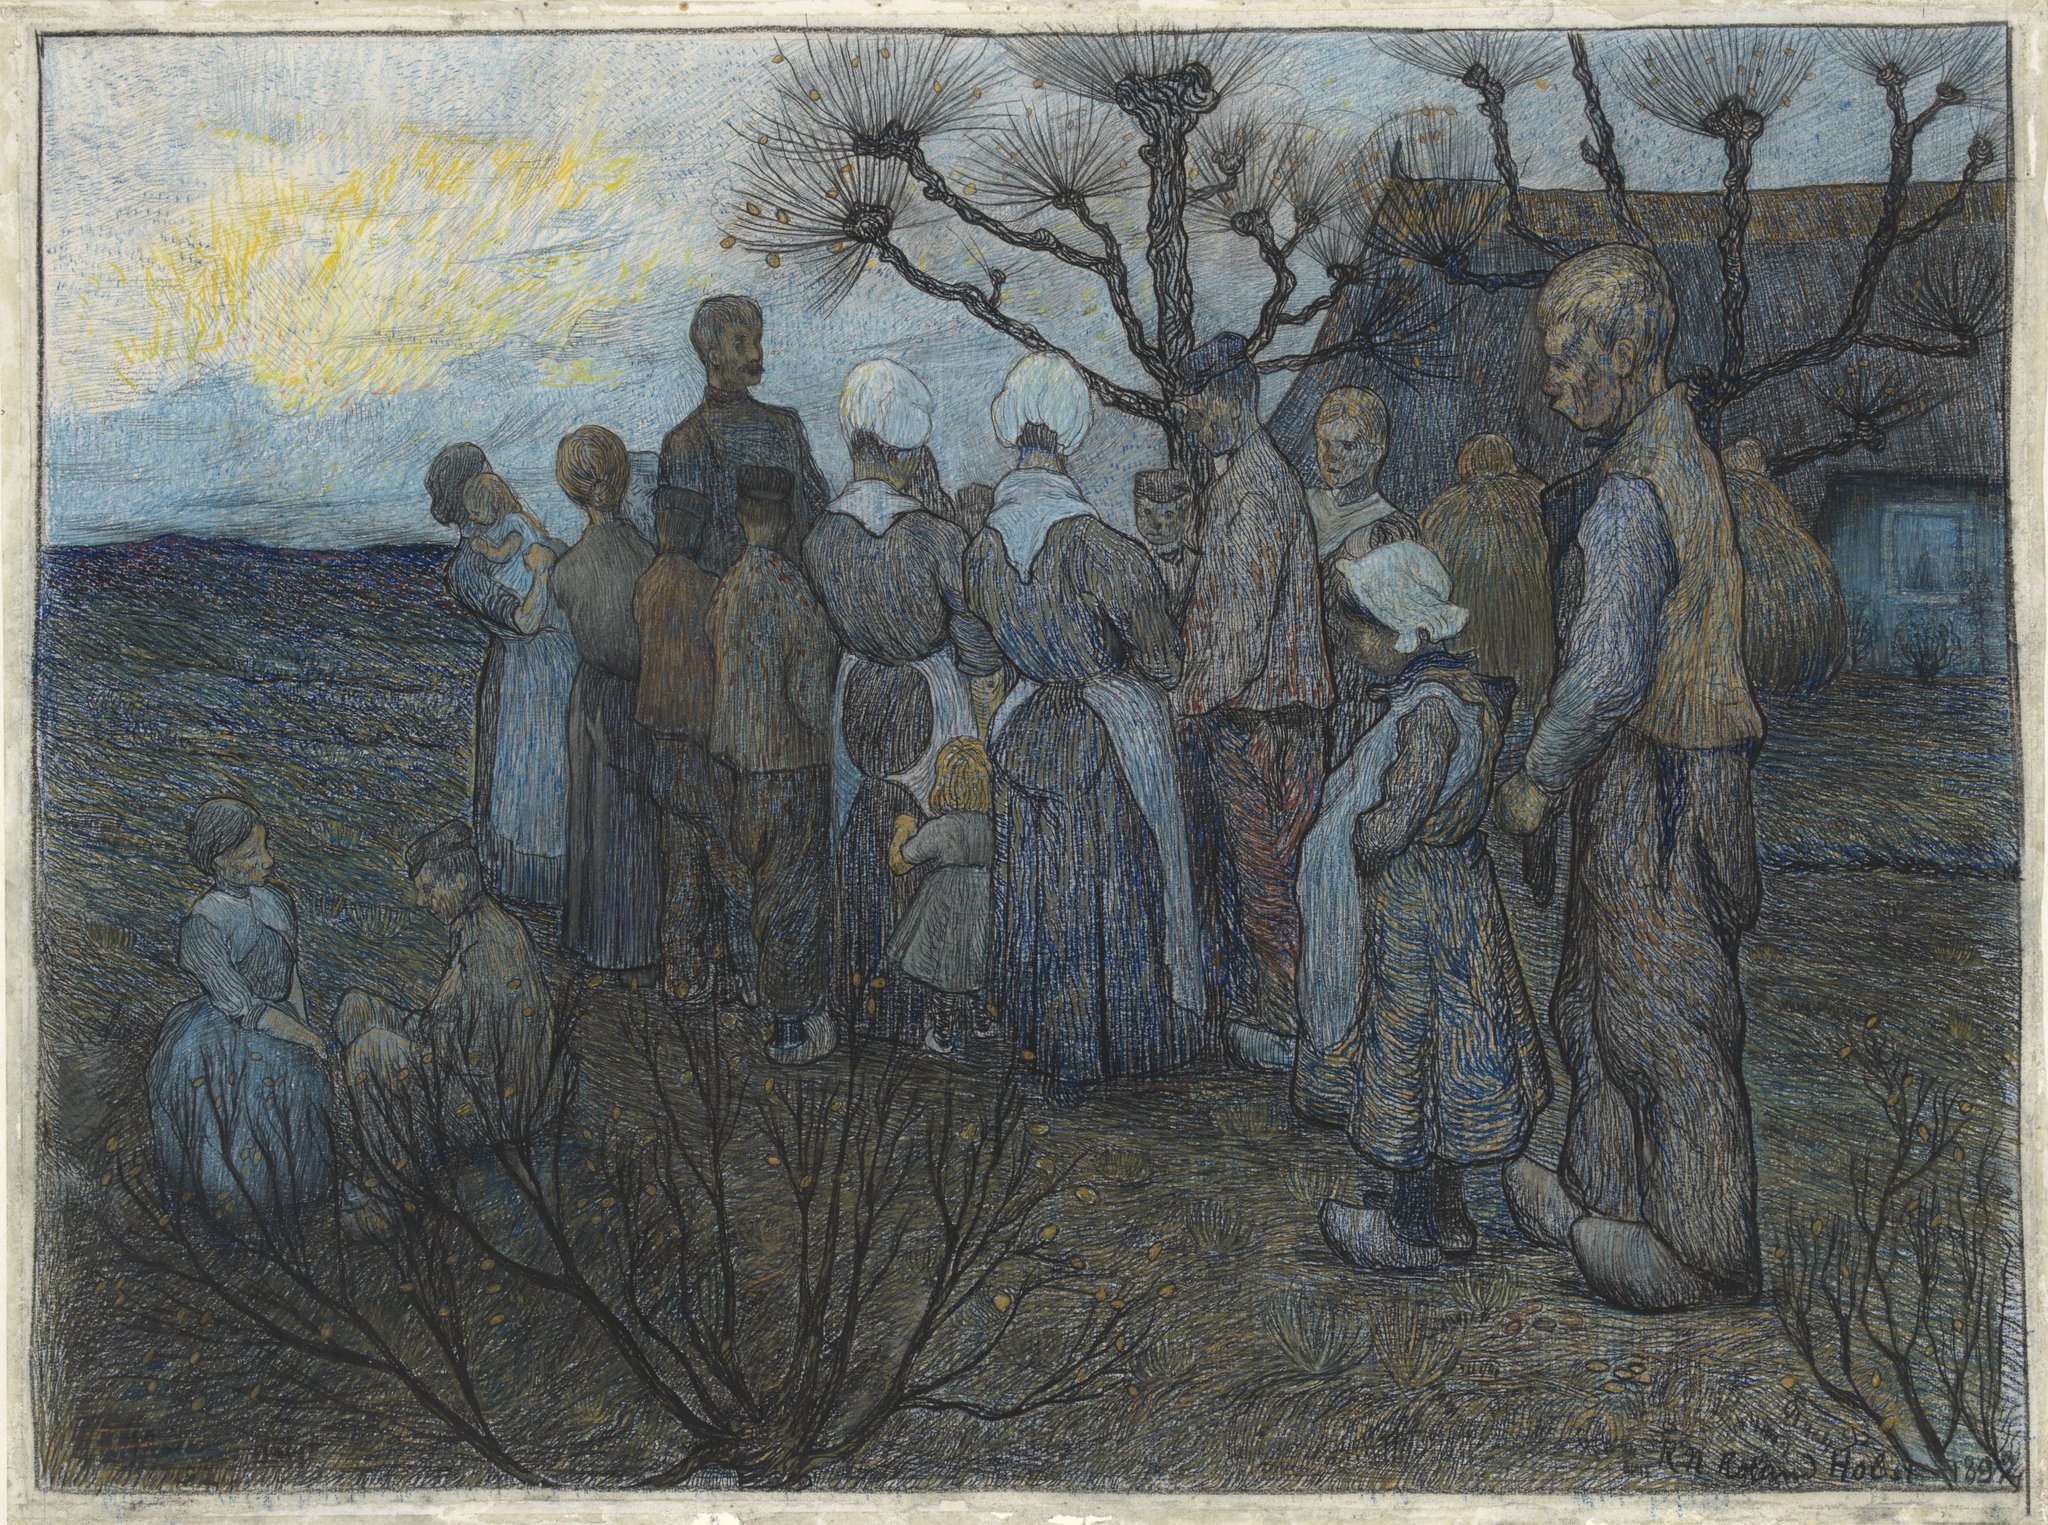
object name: drawing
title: De veldprediking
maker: richard nicolaüs roland holst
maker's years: 1868-1938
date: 1892-1897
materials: chalk, paper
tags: sermon ~ protestant service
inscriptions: date